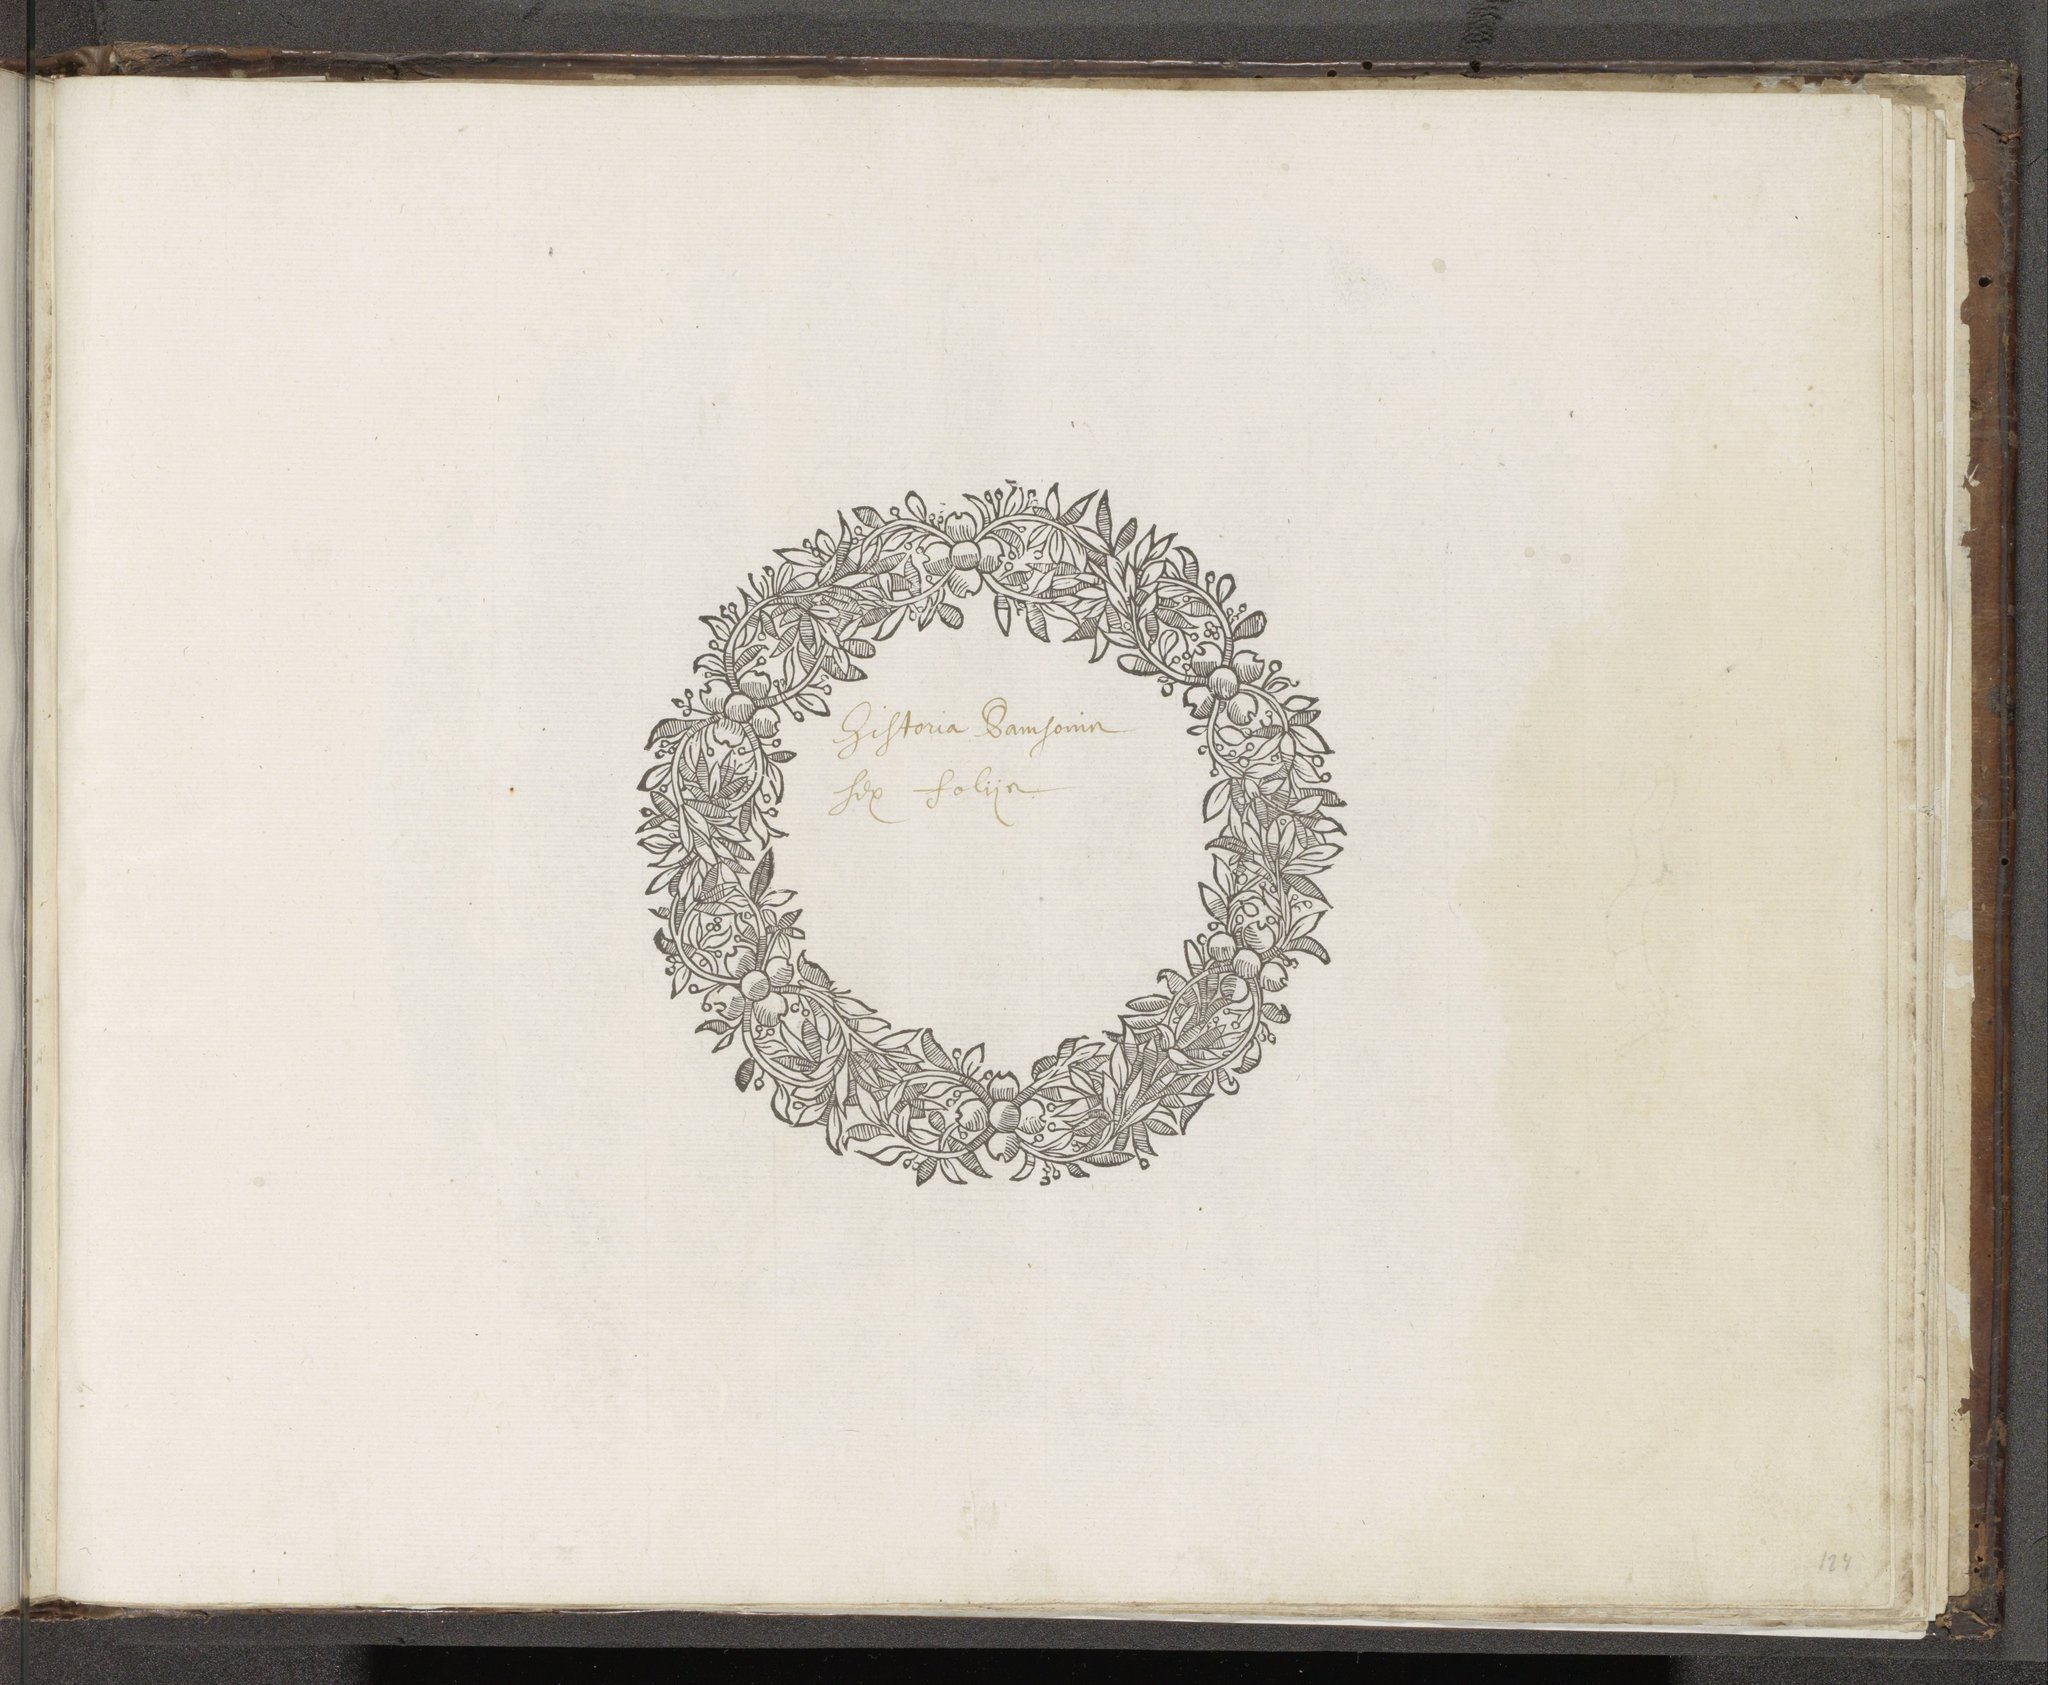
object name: album leaf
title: Ornamentele bloemenkrans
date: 1579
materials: paper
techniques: woodcut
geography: antwerp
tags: garland, wreath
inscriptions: inscription: ‘Historia Samsonia sive folijn’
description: Ornamentele bloemenkrans met in het midden een handgeschreven titel. Prent maakt deel uit van een album.